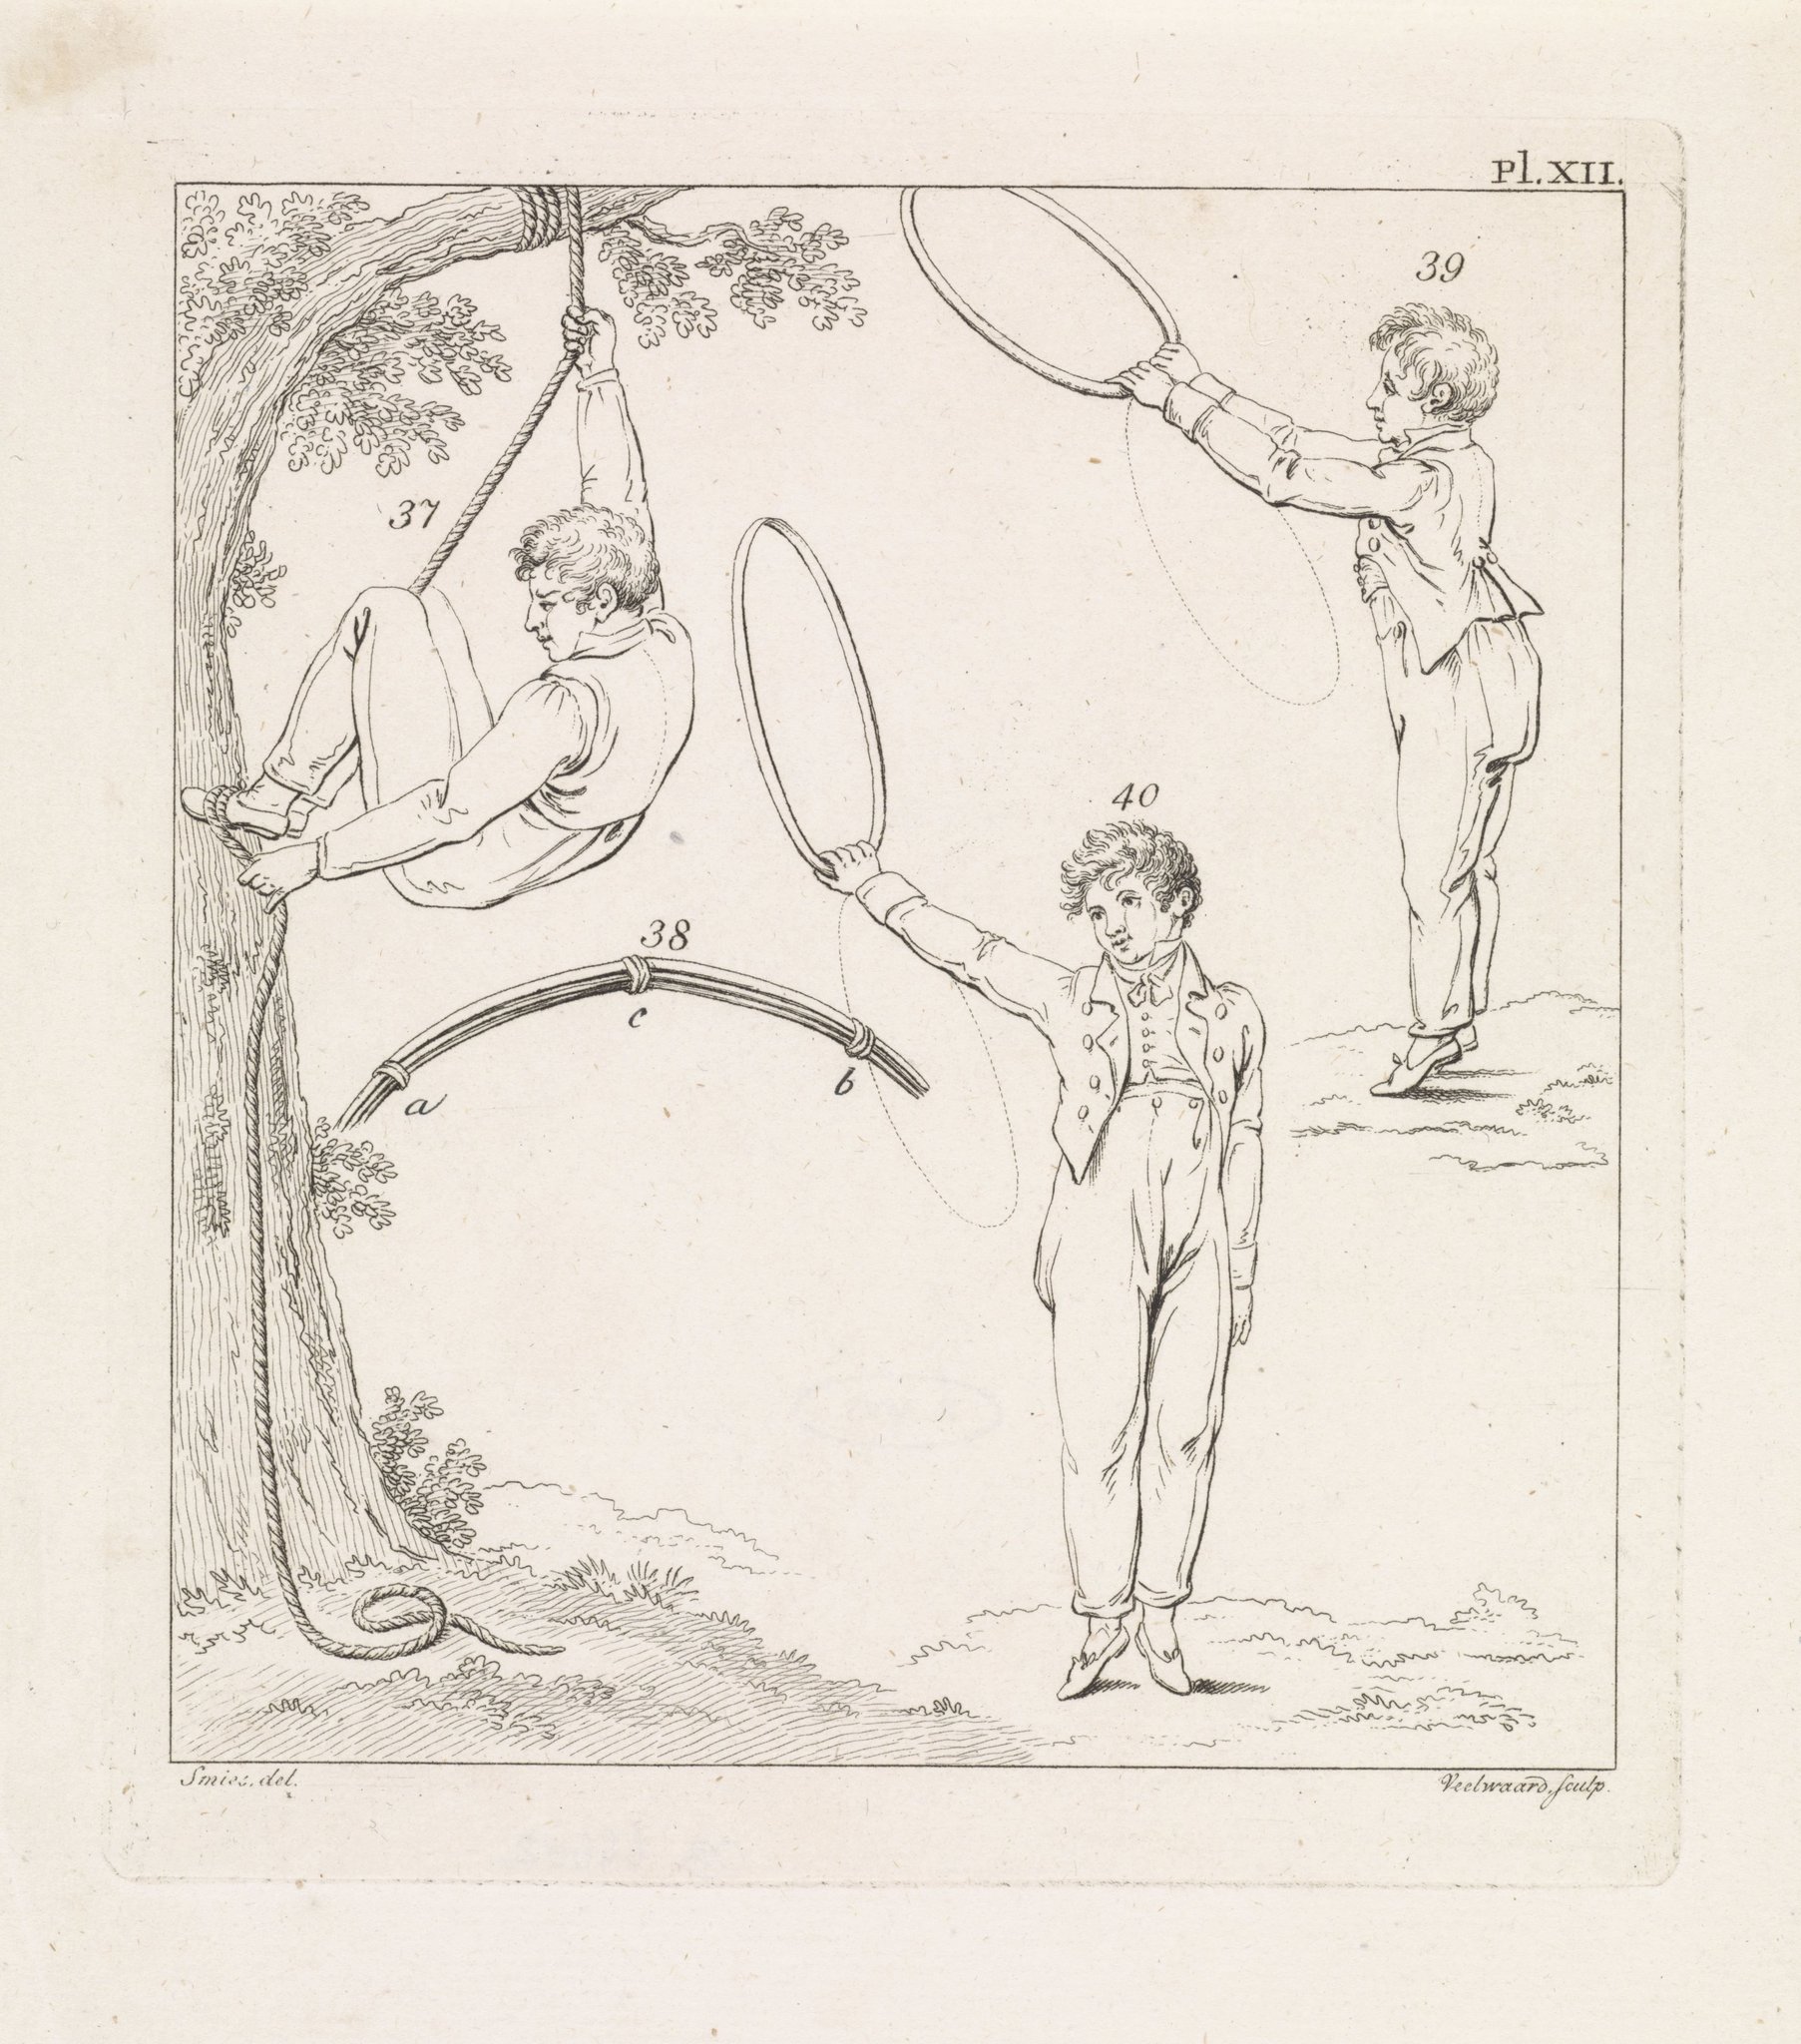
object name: book illustration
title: Lichamelijke oefeningen; klimmen en hoepels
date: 1806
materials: paper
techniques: etching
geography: amsterdam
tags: gymnastic exercises on the ground, games using special objects (marbles, top, hoop, etc.), climbing up a tree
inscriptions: collector's mark: Lugt 2228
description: Prent ook gebruikt als boekillustratie in: Geuns, Jan van. [naar J.C.F. Gutsmuths]. Volledig leerstelsel van kunstmatige ligchaams-oefeningen. Eene bijdrage tot de opvoeding der Jeugd. 2 dln. Leiden en Haarlem: 1806-1812.